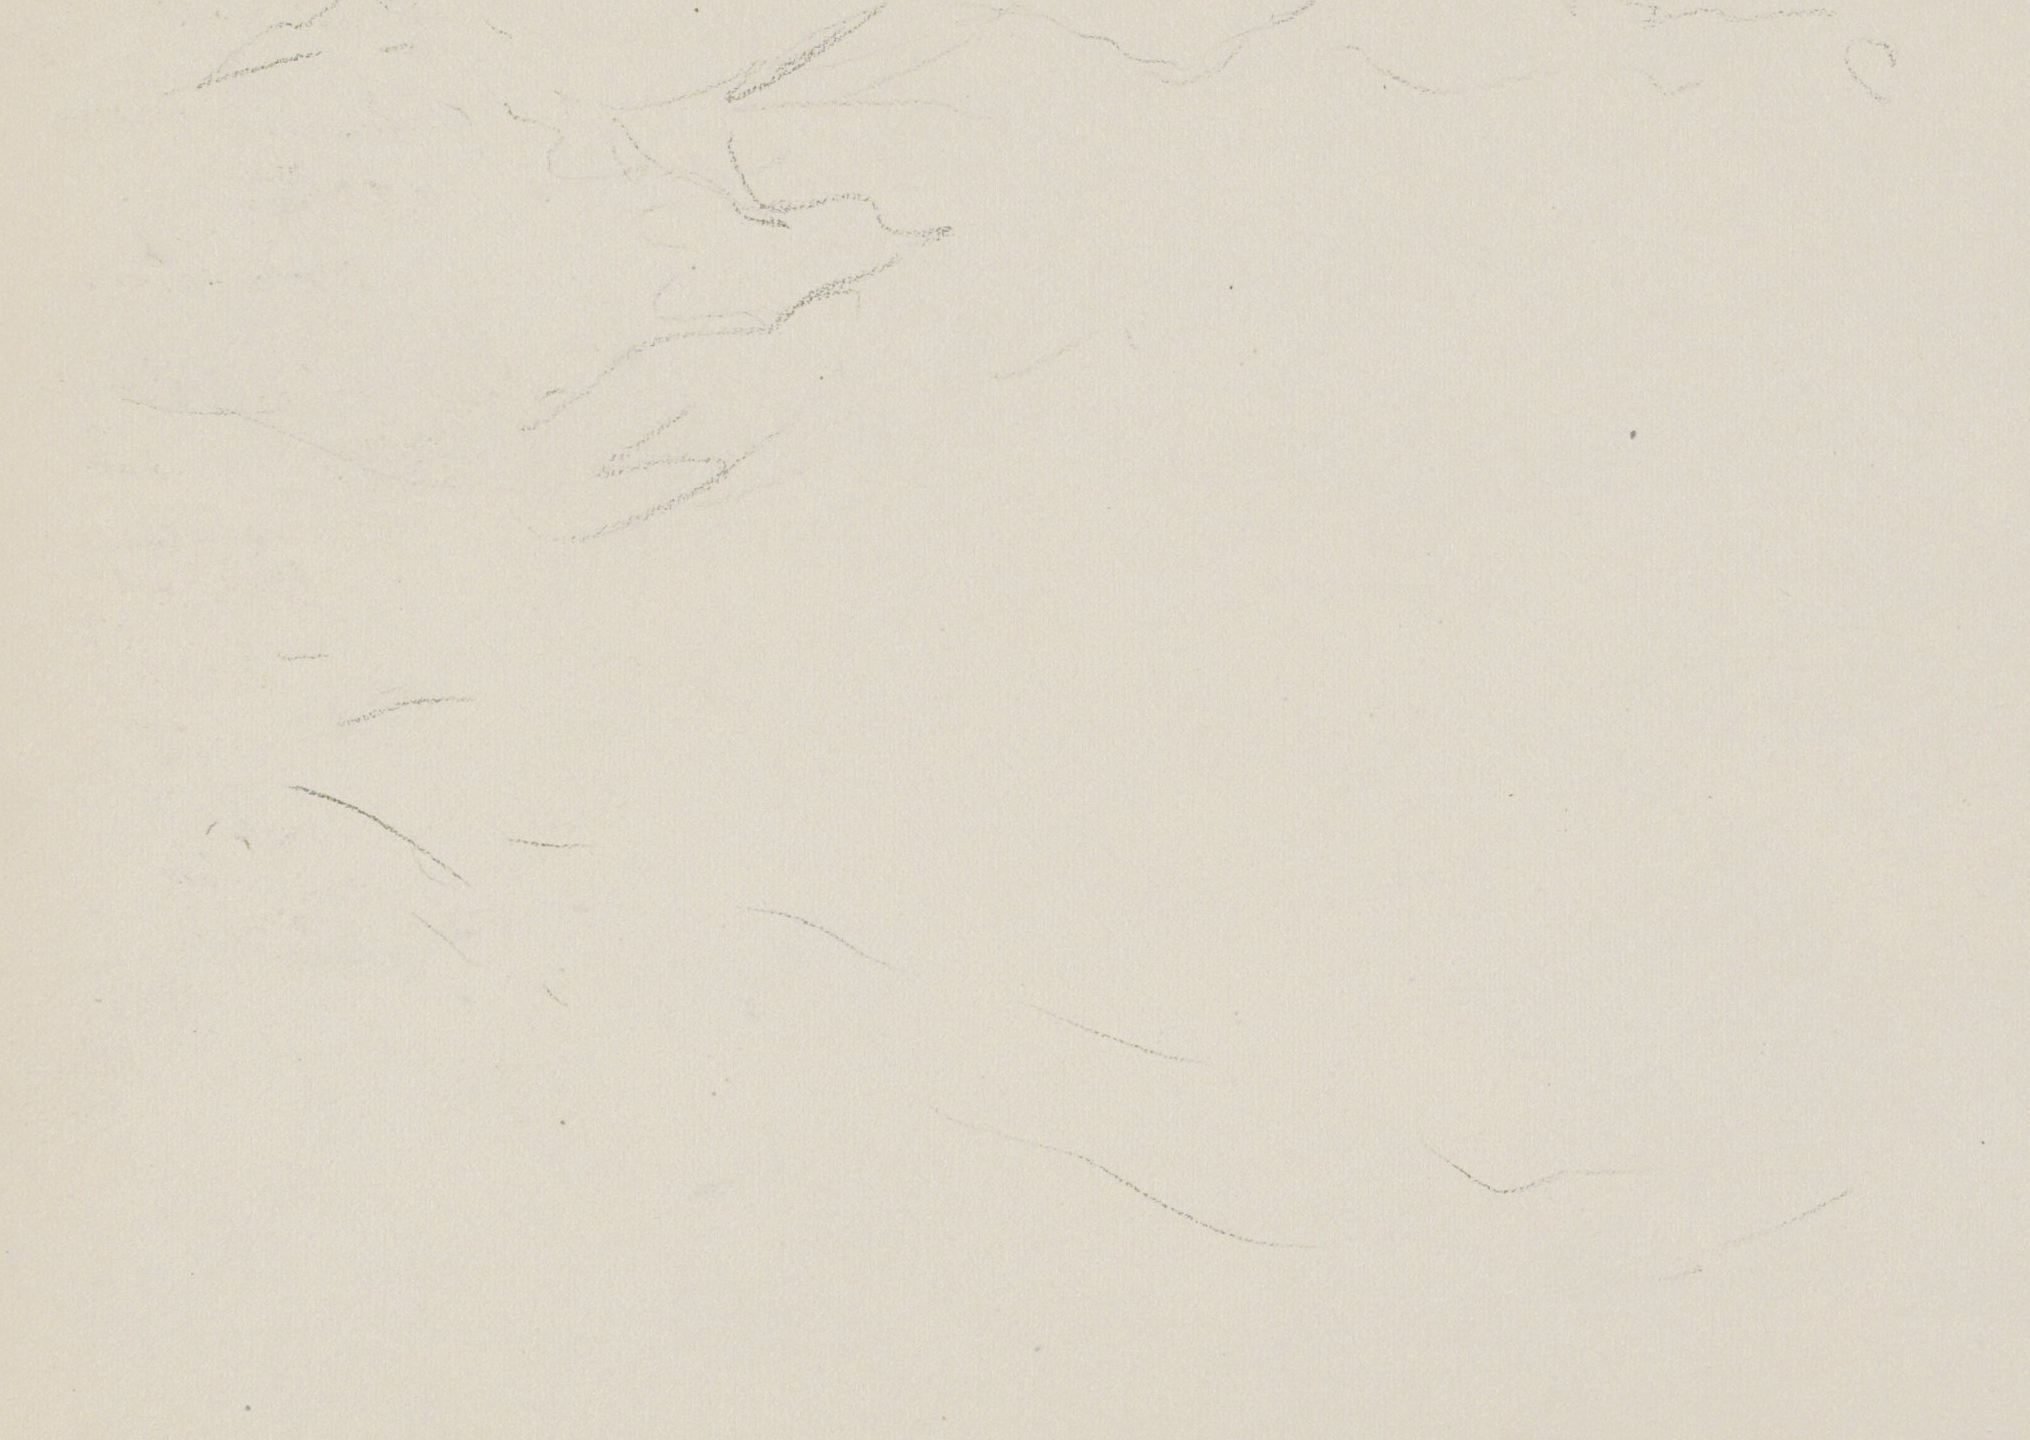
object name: sketchbook leaf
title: Duinlandschap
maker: johan antonie de jonge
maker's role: draughtsman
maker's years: 1864-1927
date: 1881-1927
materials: chalk, paper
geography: south holland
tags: dunes (sea not visible); in the dunes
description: Duinlandschap. Blad 21 verso uit een schetsboek met 28 bladen.